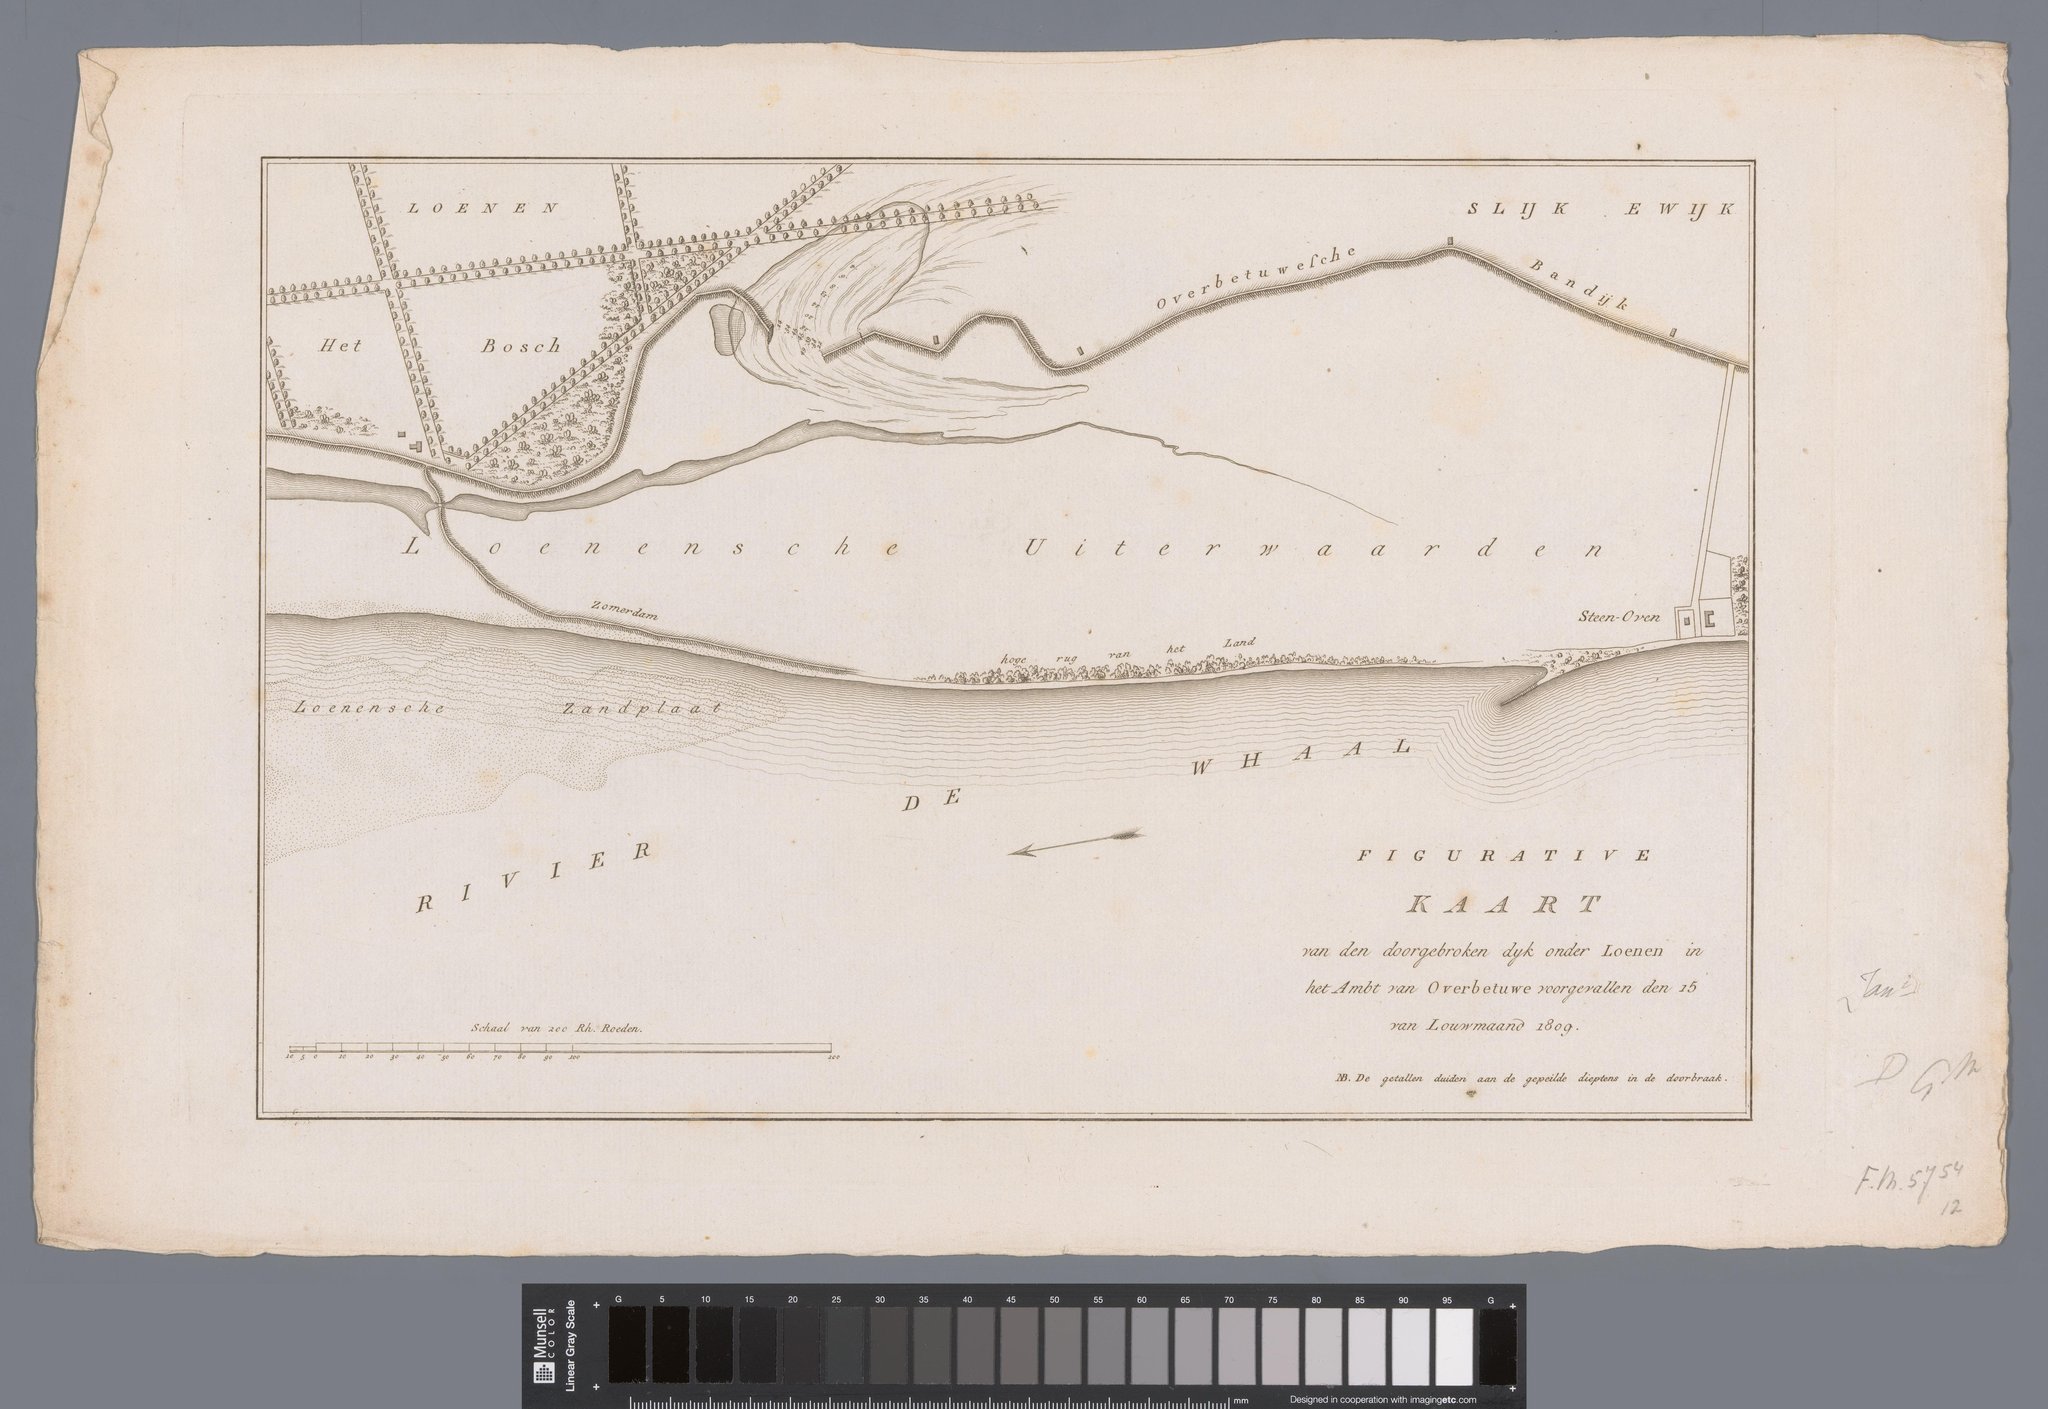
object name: print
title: Figurative Kaart van den doorgebroken dijk onder Loenen in het Ambt van Overbetuwe voorgevallen den 15 van Louwmaand 1809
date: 1809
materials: paper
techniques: etching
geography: amsterdam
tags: dike-break, maps of separate countries or regions, gelderland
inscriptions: collector's mark: Lugt 2228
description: Prent uit: Ewijk, Hendrik. Geschiedkundig verslag der dijkbreuken en overstroomingen, langs de rivieren in het Koningrijk Holland, voorgevallen in louwmaand MDCCCIX. Amsterdam: Johannes Allart en Jacobus Ruys, 1809.